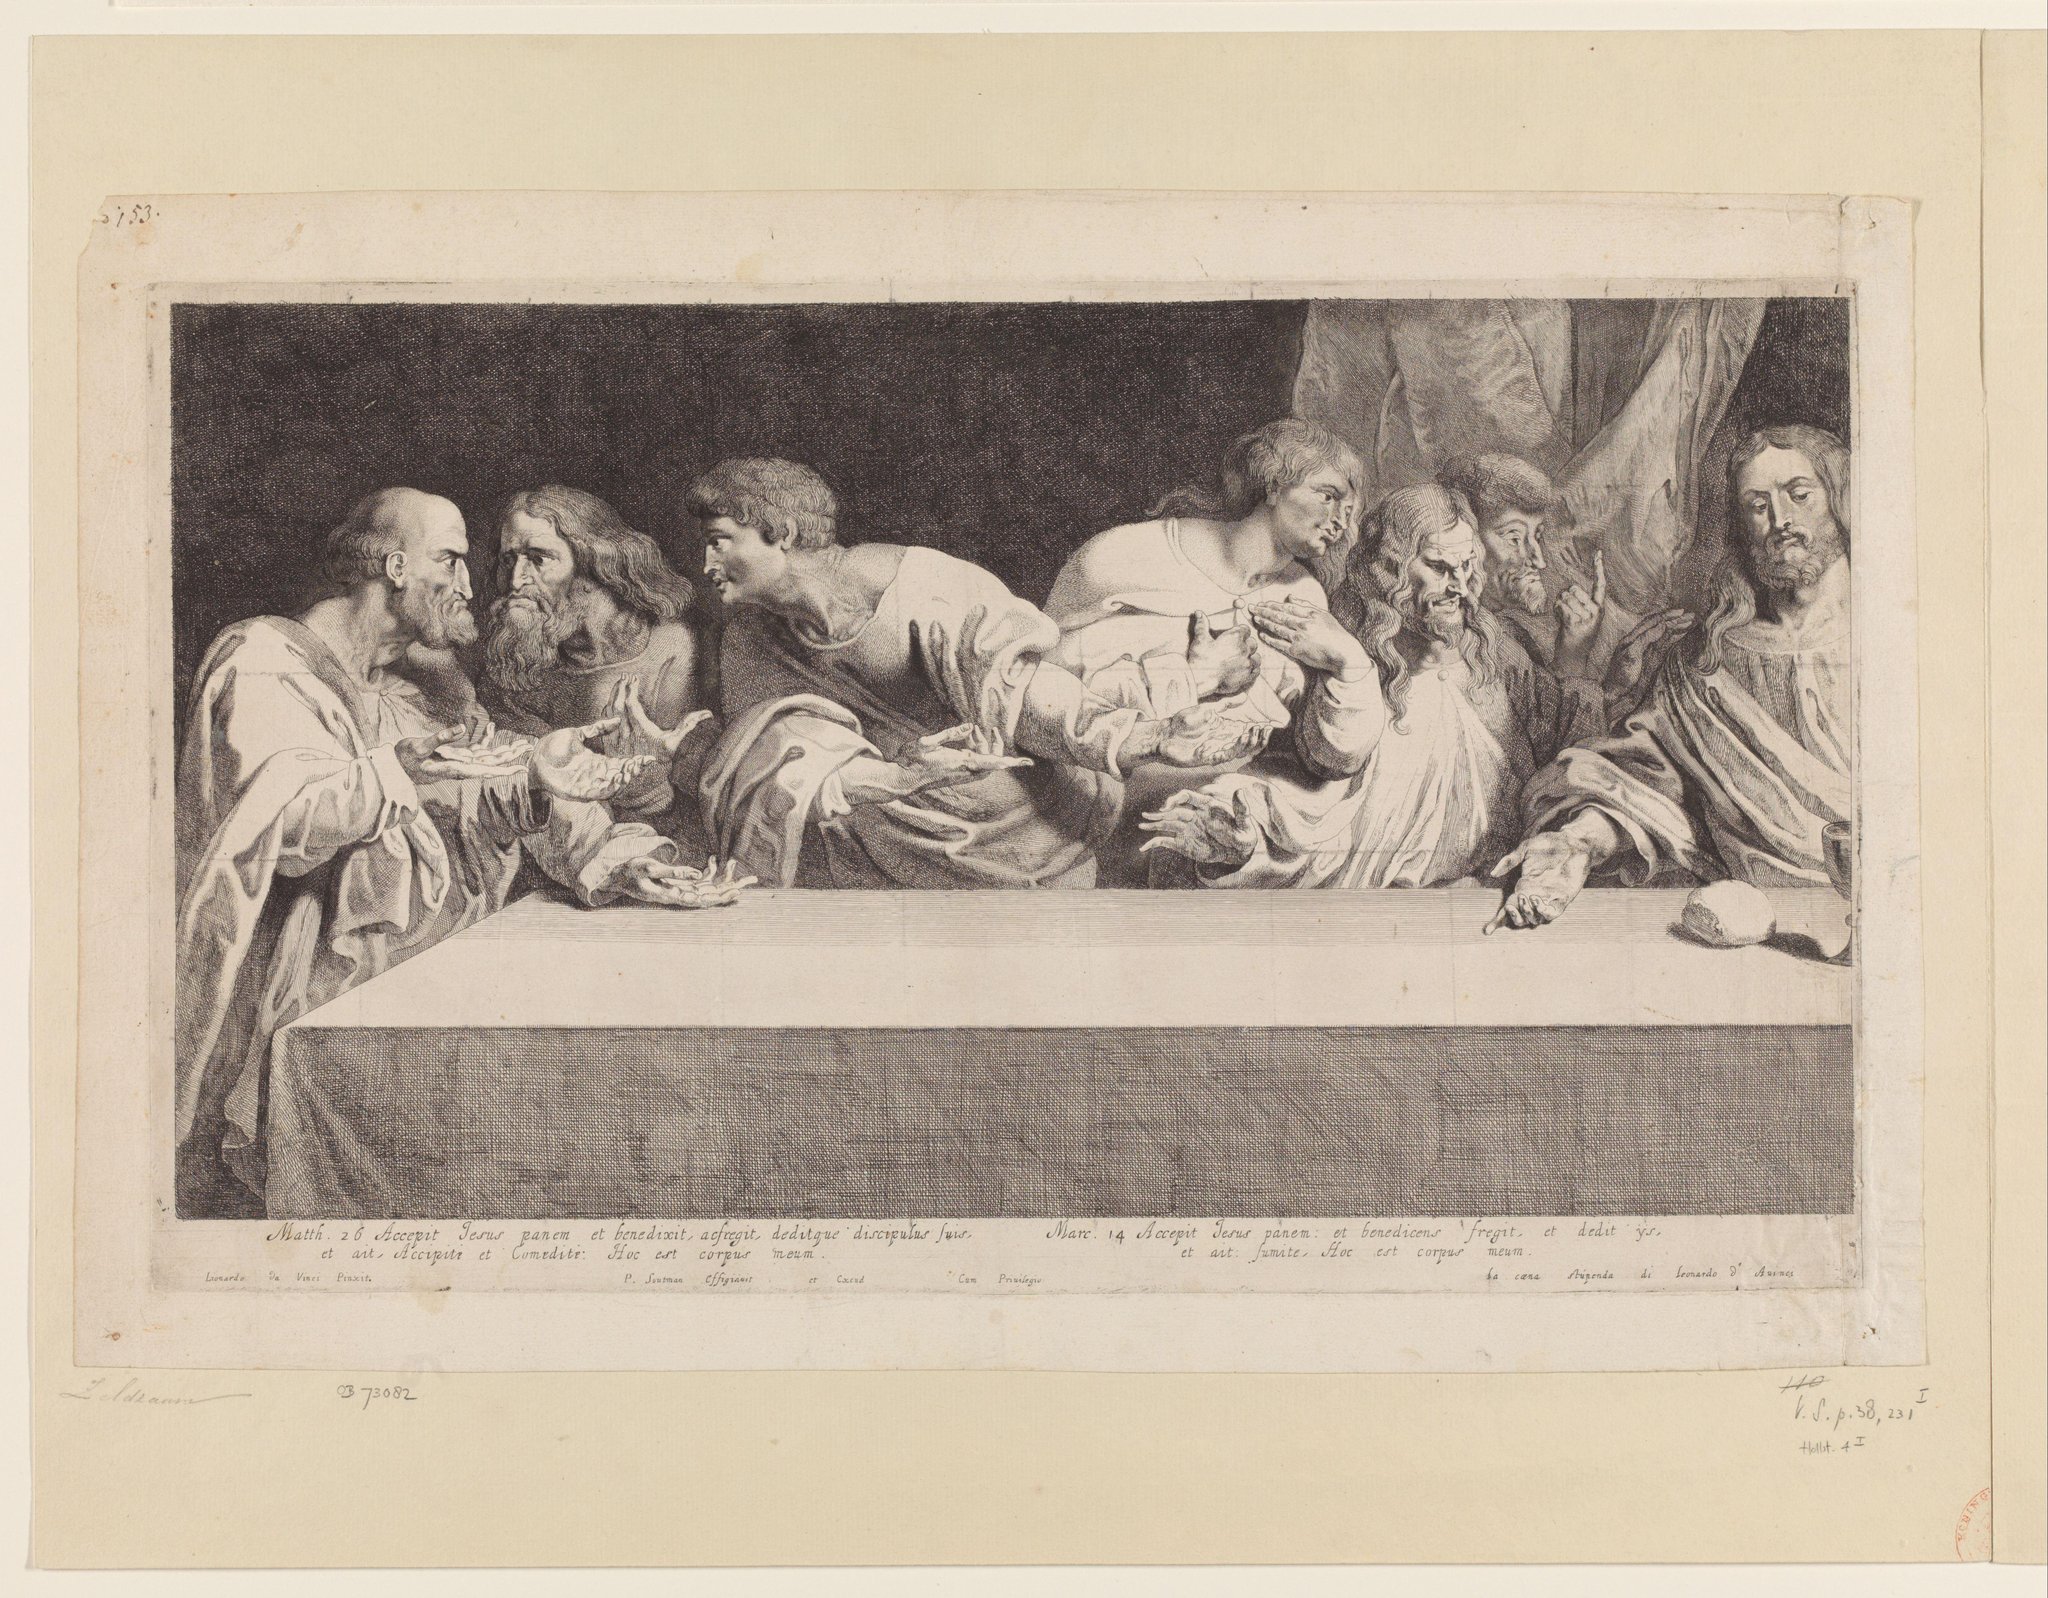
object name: print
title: Het Laatste Avondmaal (linkerhelft)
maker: pieter claesz. soutman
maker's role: draughtsman, print maker, publisher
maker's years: 1593-1657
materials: paper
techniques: etching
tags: last supper (in general) (matthew 26:21-35; mark 14:18-31; luke 22:3, 22:15-23; john 13:21-38)